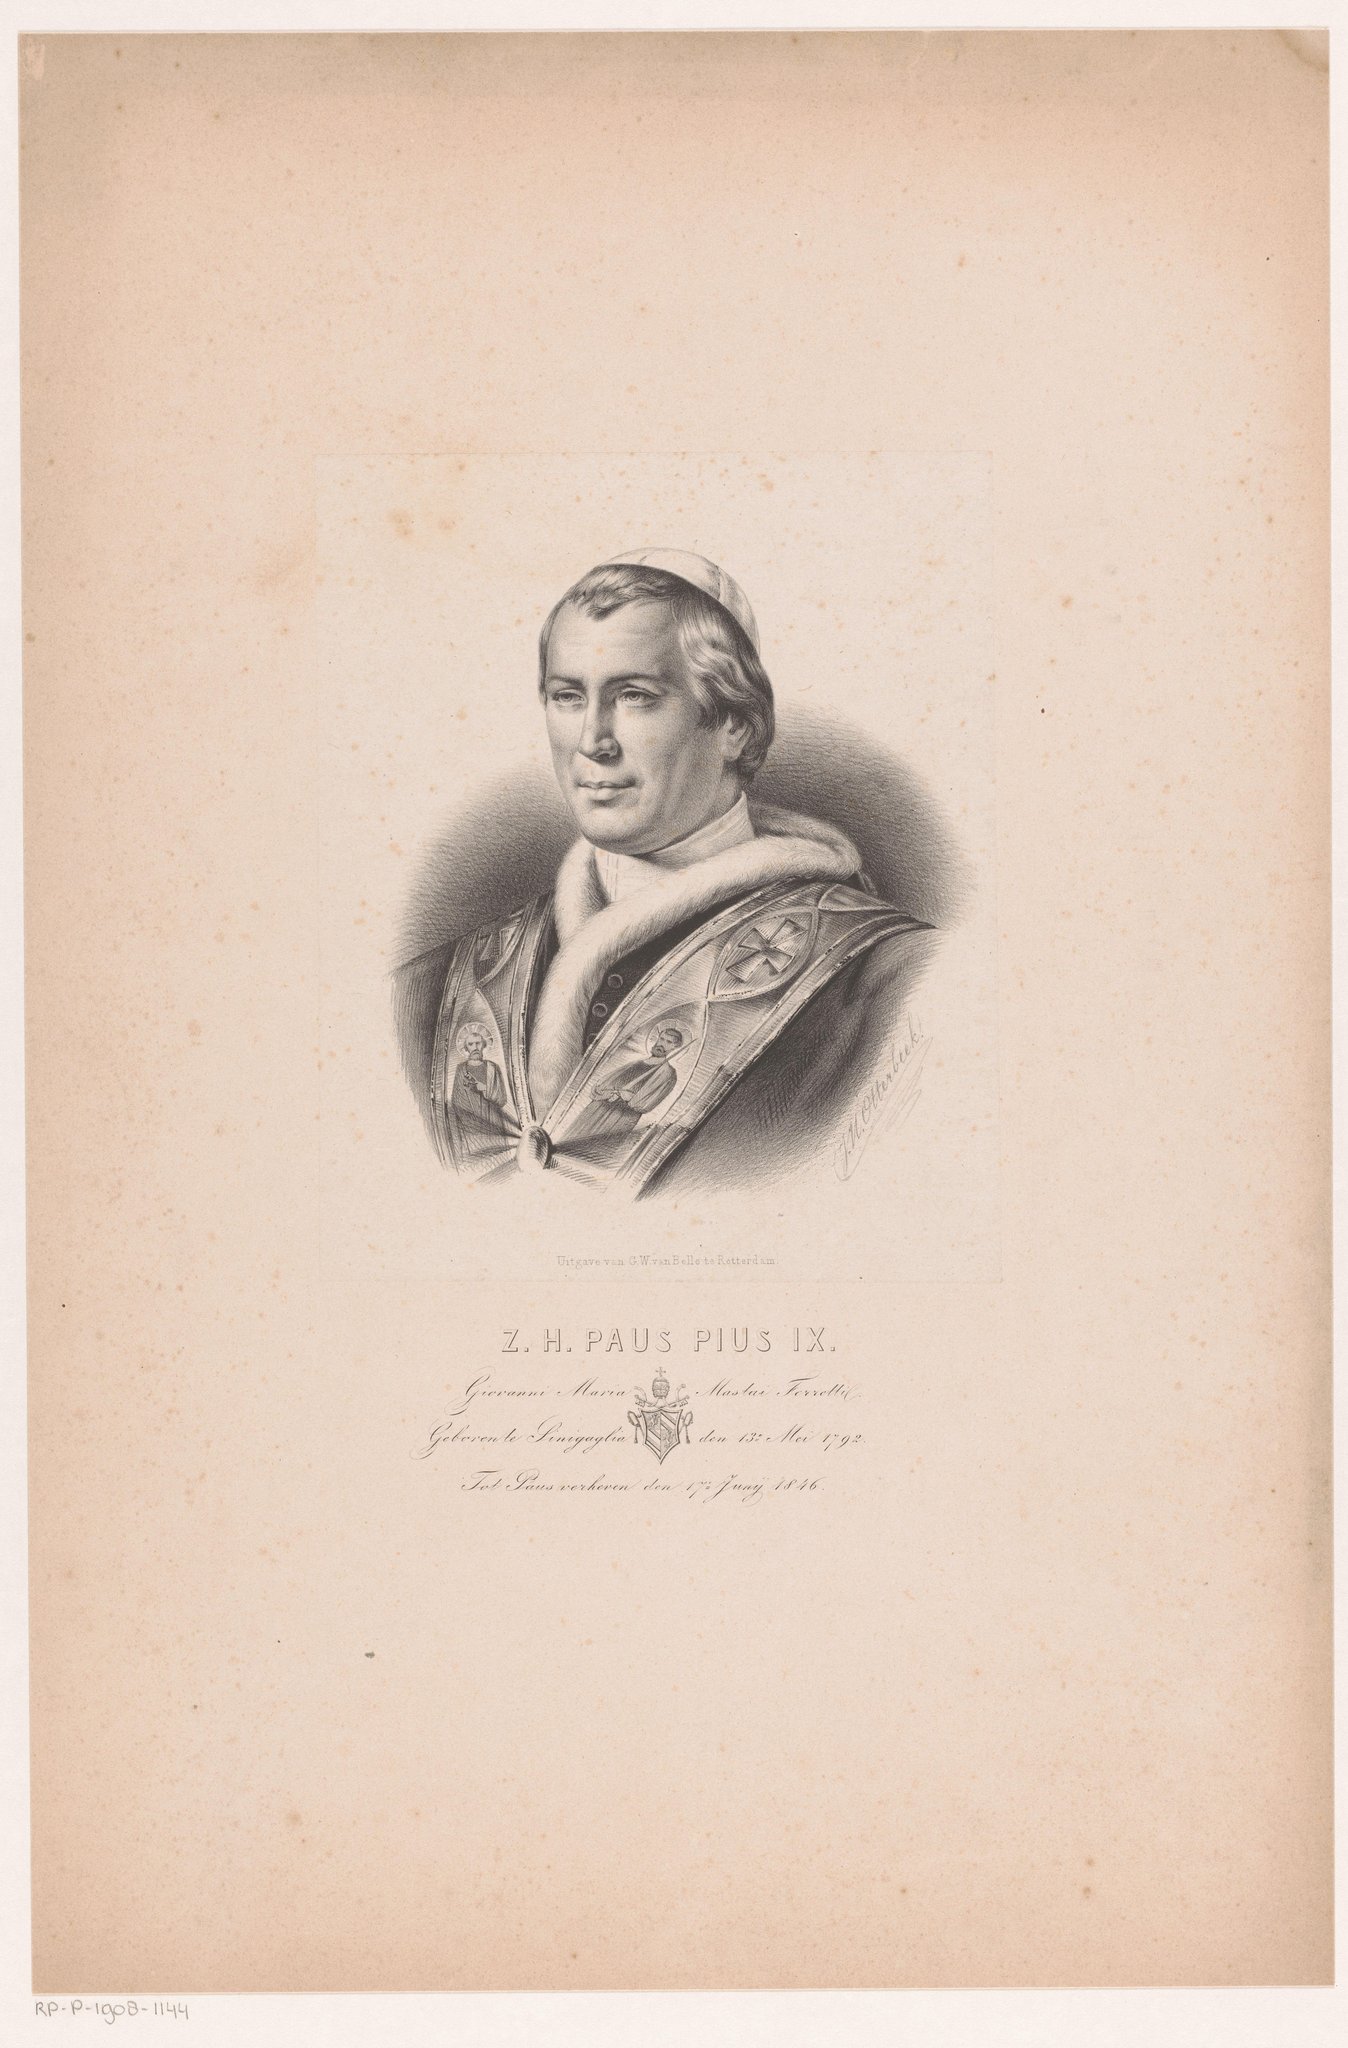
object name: print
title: Portret van paus Pius IX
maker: gerardus wilhelmus van belle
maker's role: printer, publisher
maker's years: 1832-1902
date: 1855-1878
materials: paper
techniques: lithograph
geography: rotterdam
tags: rome, historical persons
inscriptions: collector's mark: Lugt 2228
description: Onder het portret het pauselijk wapen en zijn biografische gegevens.